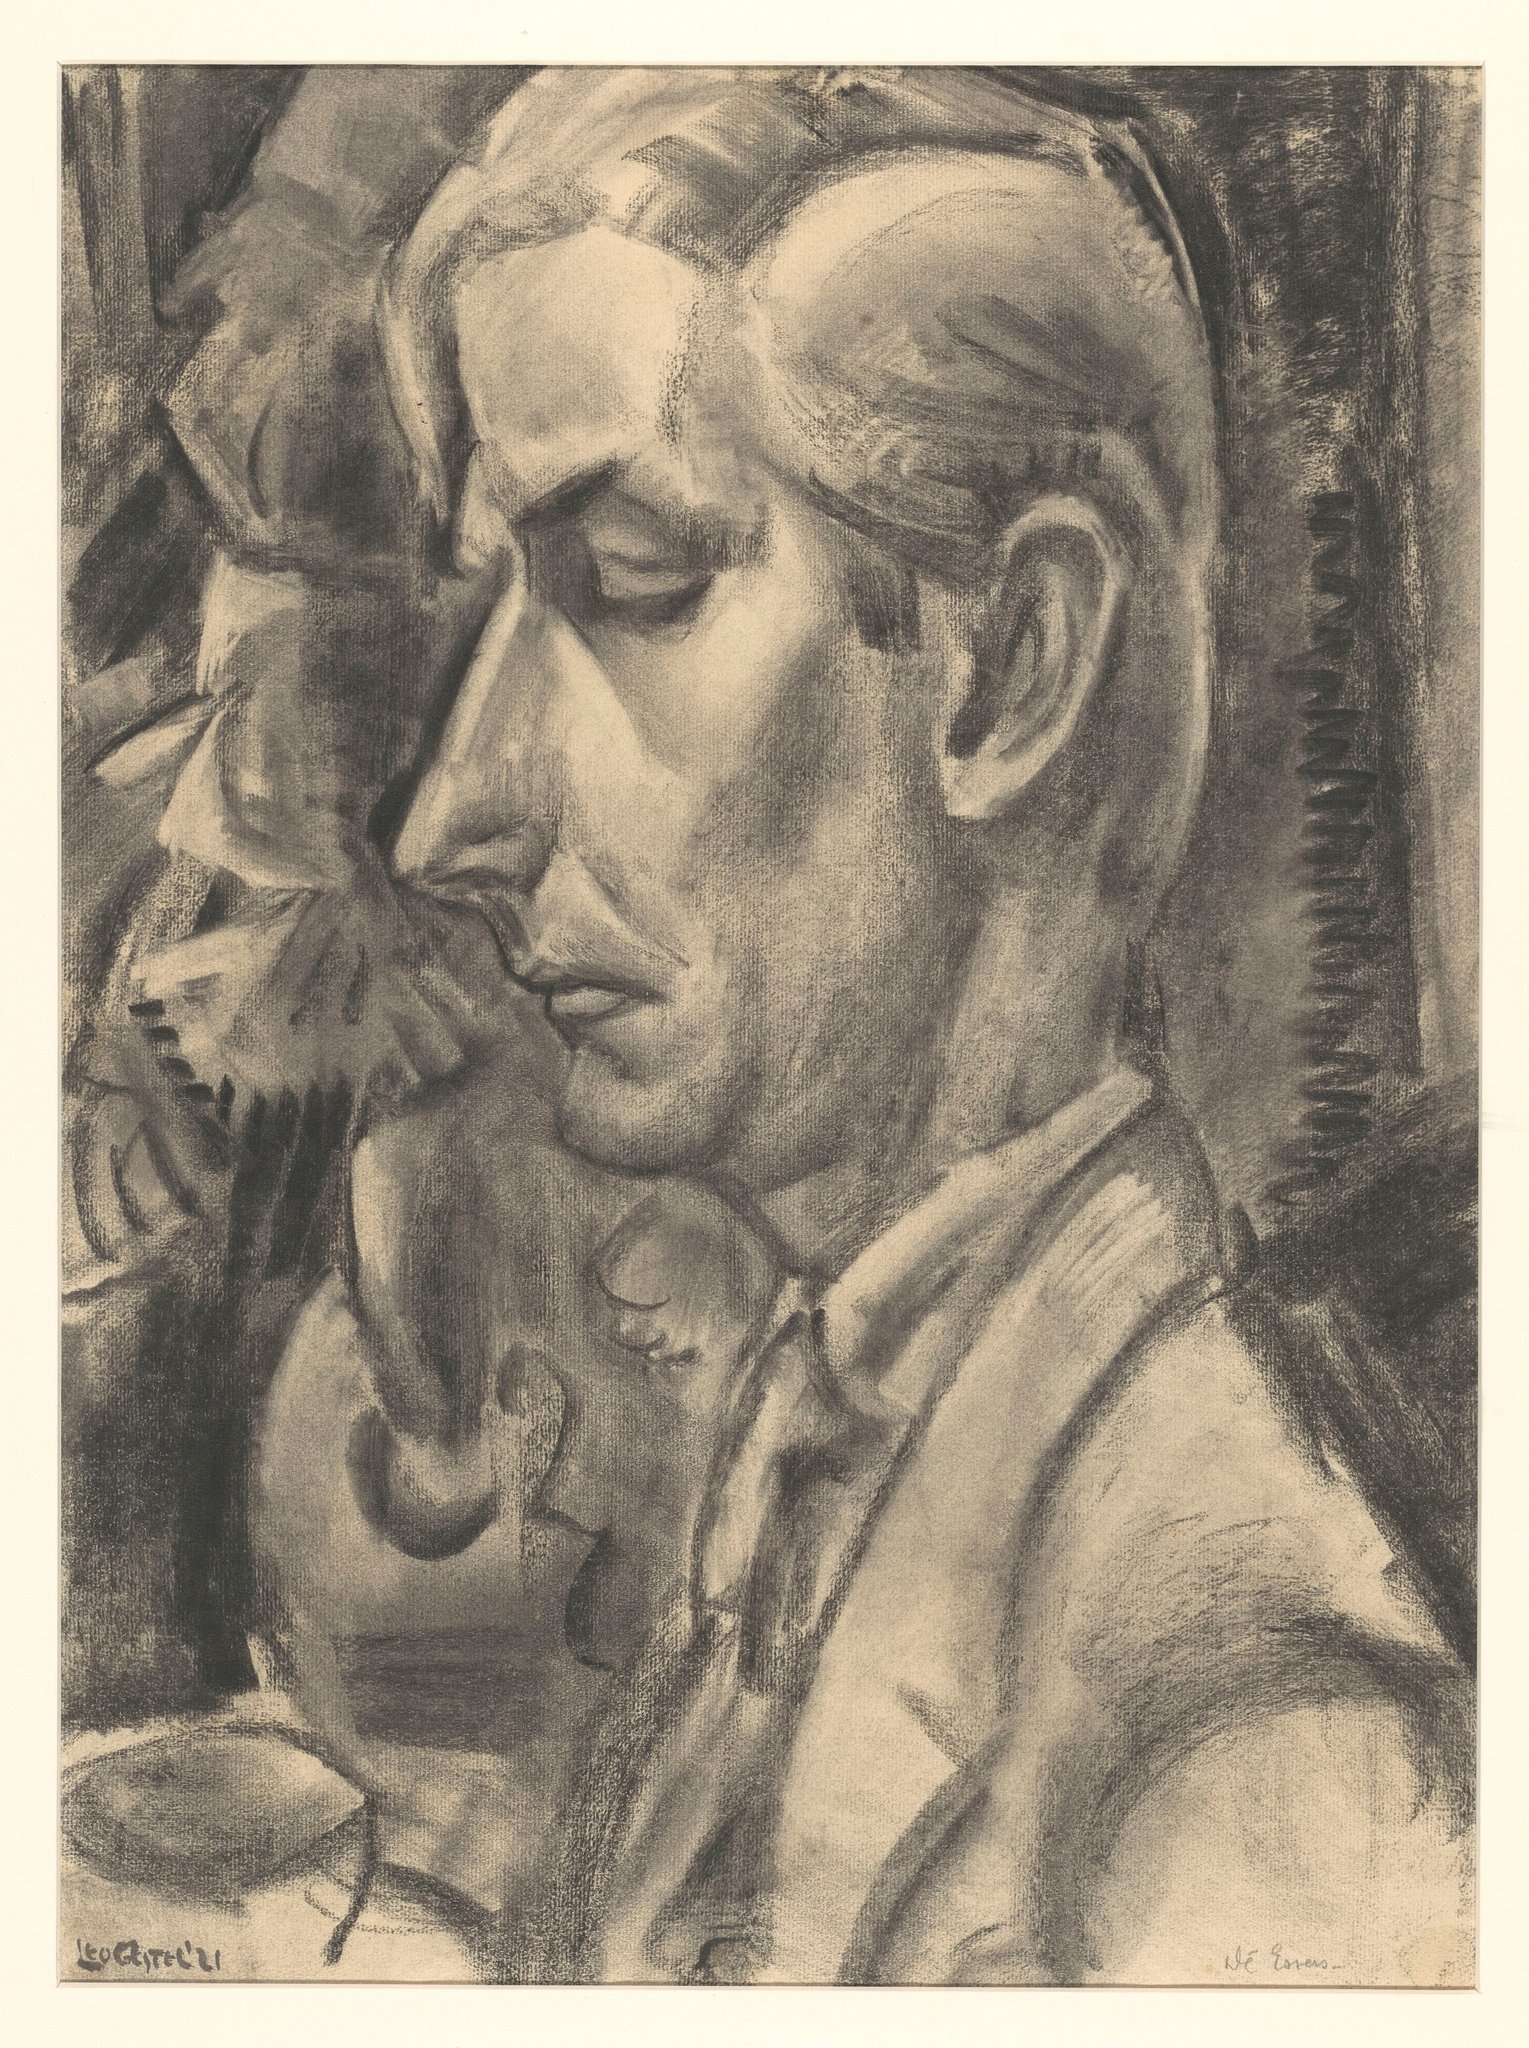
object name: drawing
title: Portret van Dé Essers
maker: leo gestel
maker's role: draughtsman, print maker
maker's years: 1881-1941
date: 1921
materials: charcoal, paper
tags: historical persons, portrait, self-portrait of artist, portrait, self-portrait of graphic artist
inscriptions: collector's mark: Lugt 2228